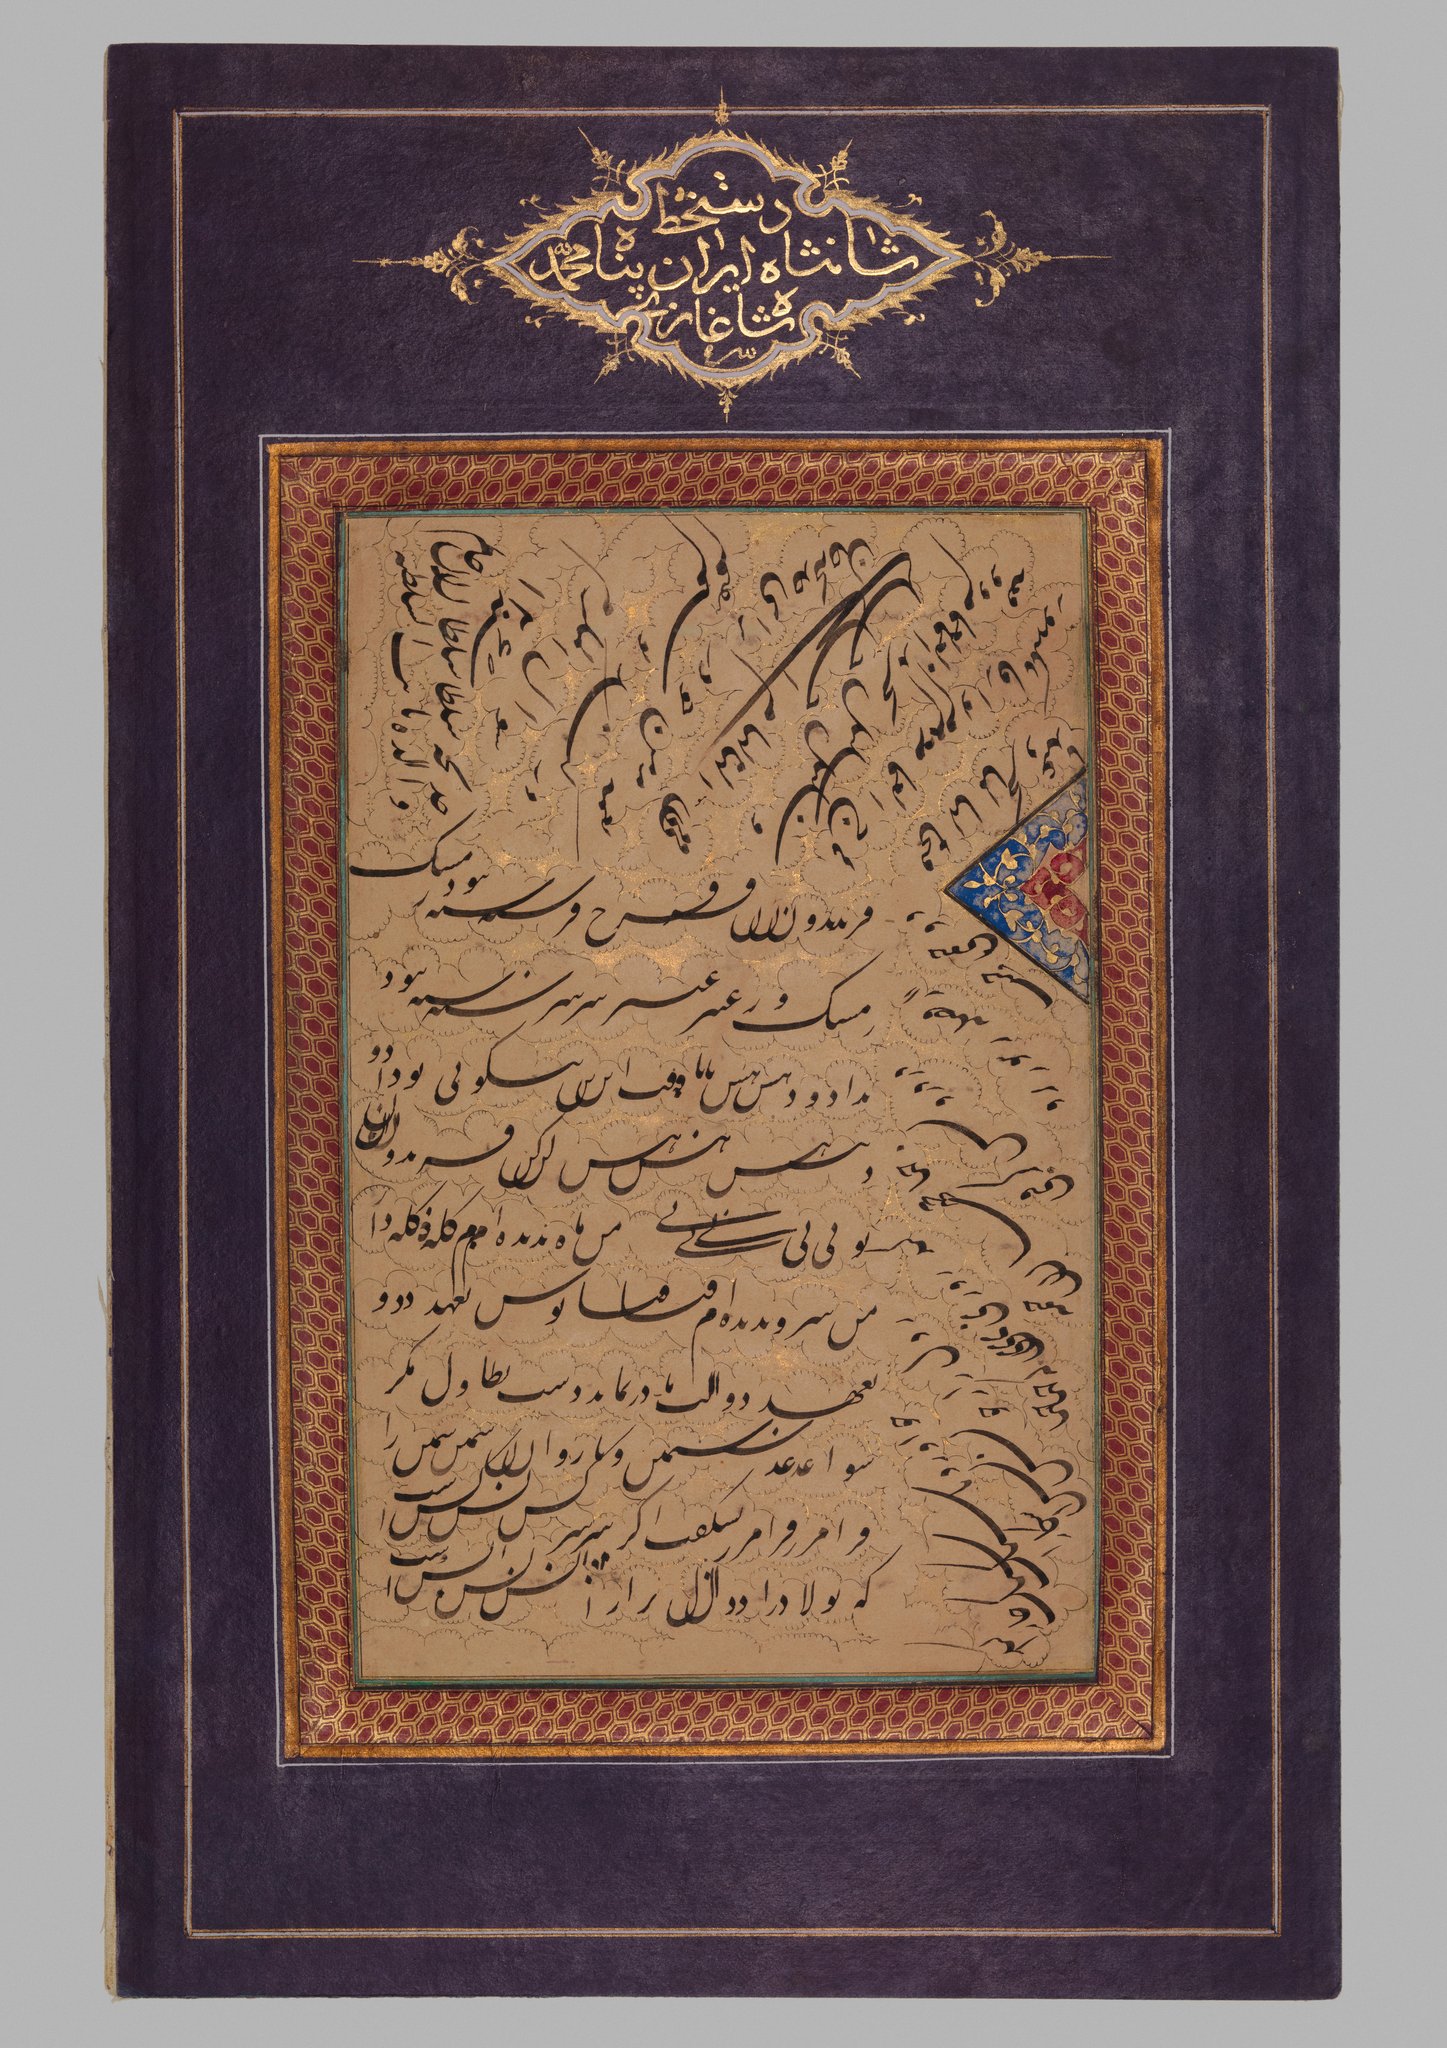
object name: non illustrated album leaf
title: Album Page with Calligraphy Exercise (siyah mashq) by Muhammad Shah Qajar (3rd Ruler of the Qajar Dynasty)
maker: muhammad shah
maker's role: calligrapher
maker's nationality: iranian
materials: gold, ink, paper, watercolor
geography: iran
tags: calligraphy